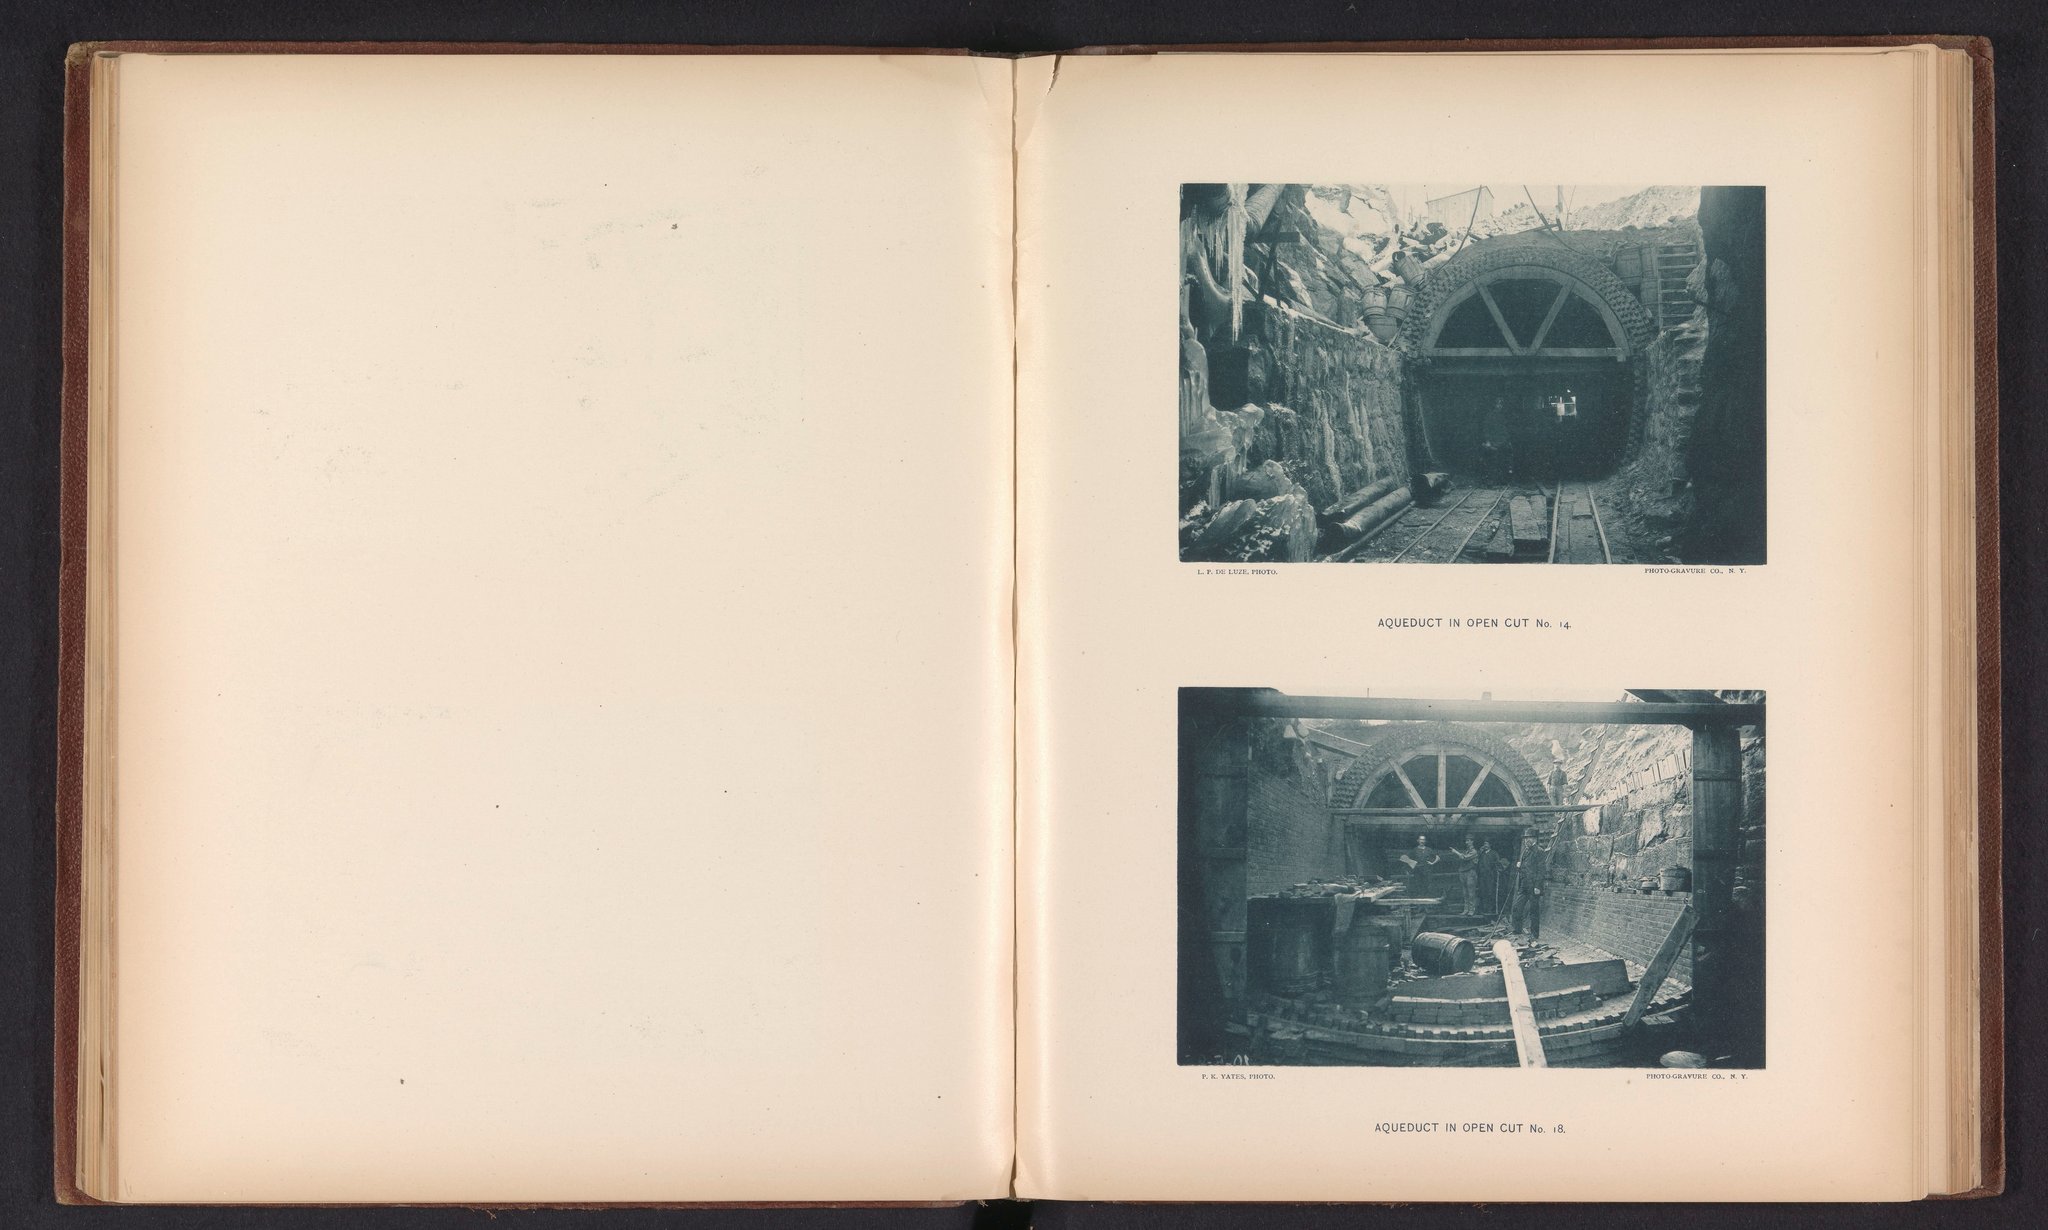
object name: page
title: Aqueduct in open cut no. 14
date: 1883-1887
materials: paper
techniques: photograph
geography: new york city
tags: working class, labourers, aqueduct (~ water supply)